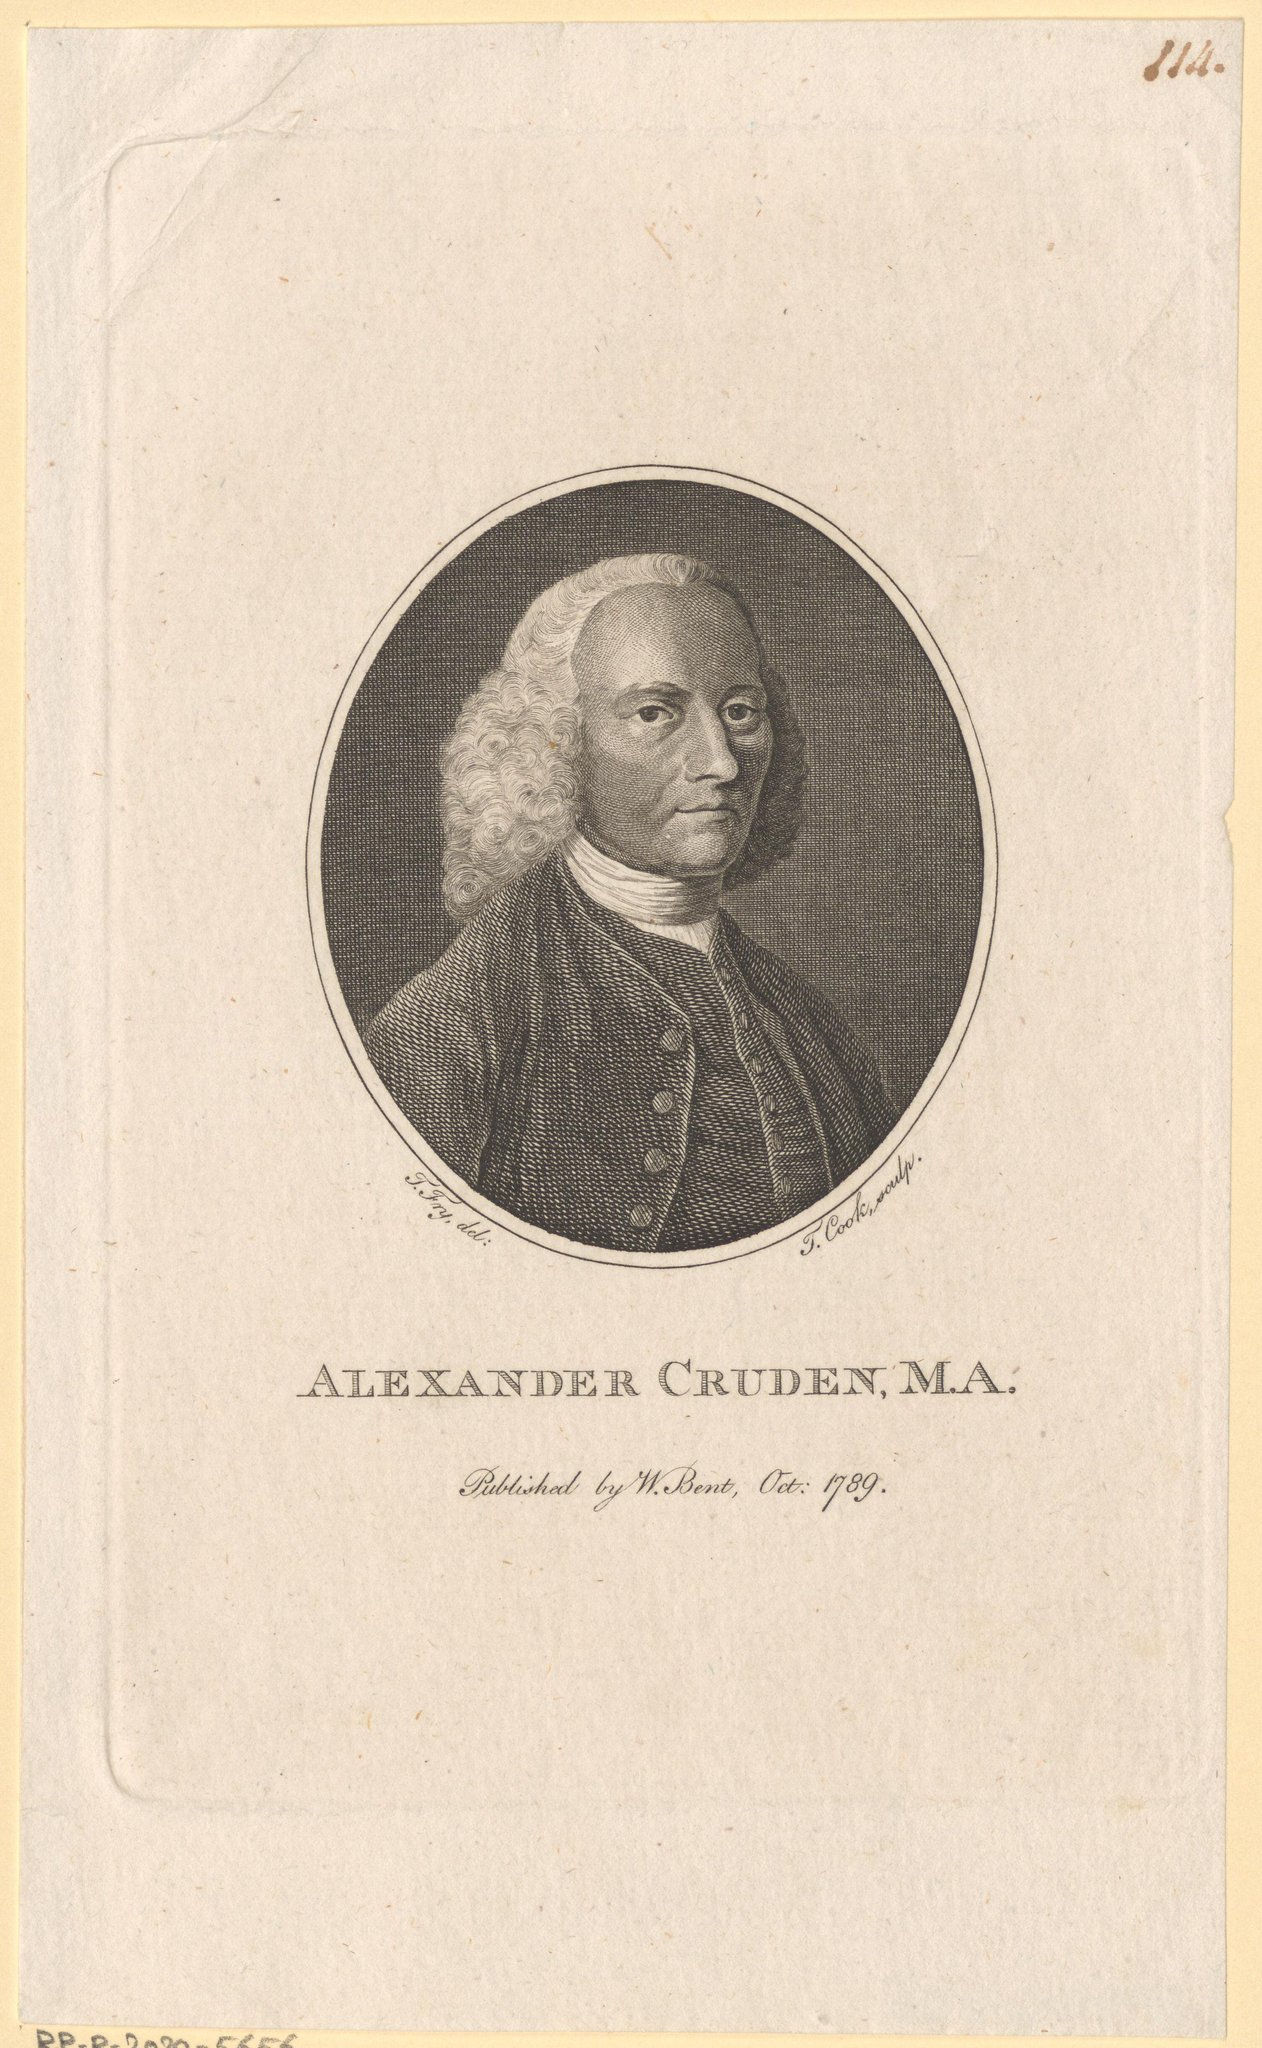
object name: print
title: Portret van Alexander Cruden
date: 1789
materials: paper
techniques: engraving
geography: london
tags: publisher, historical persons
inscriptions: date